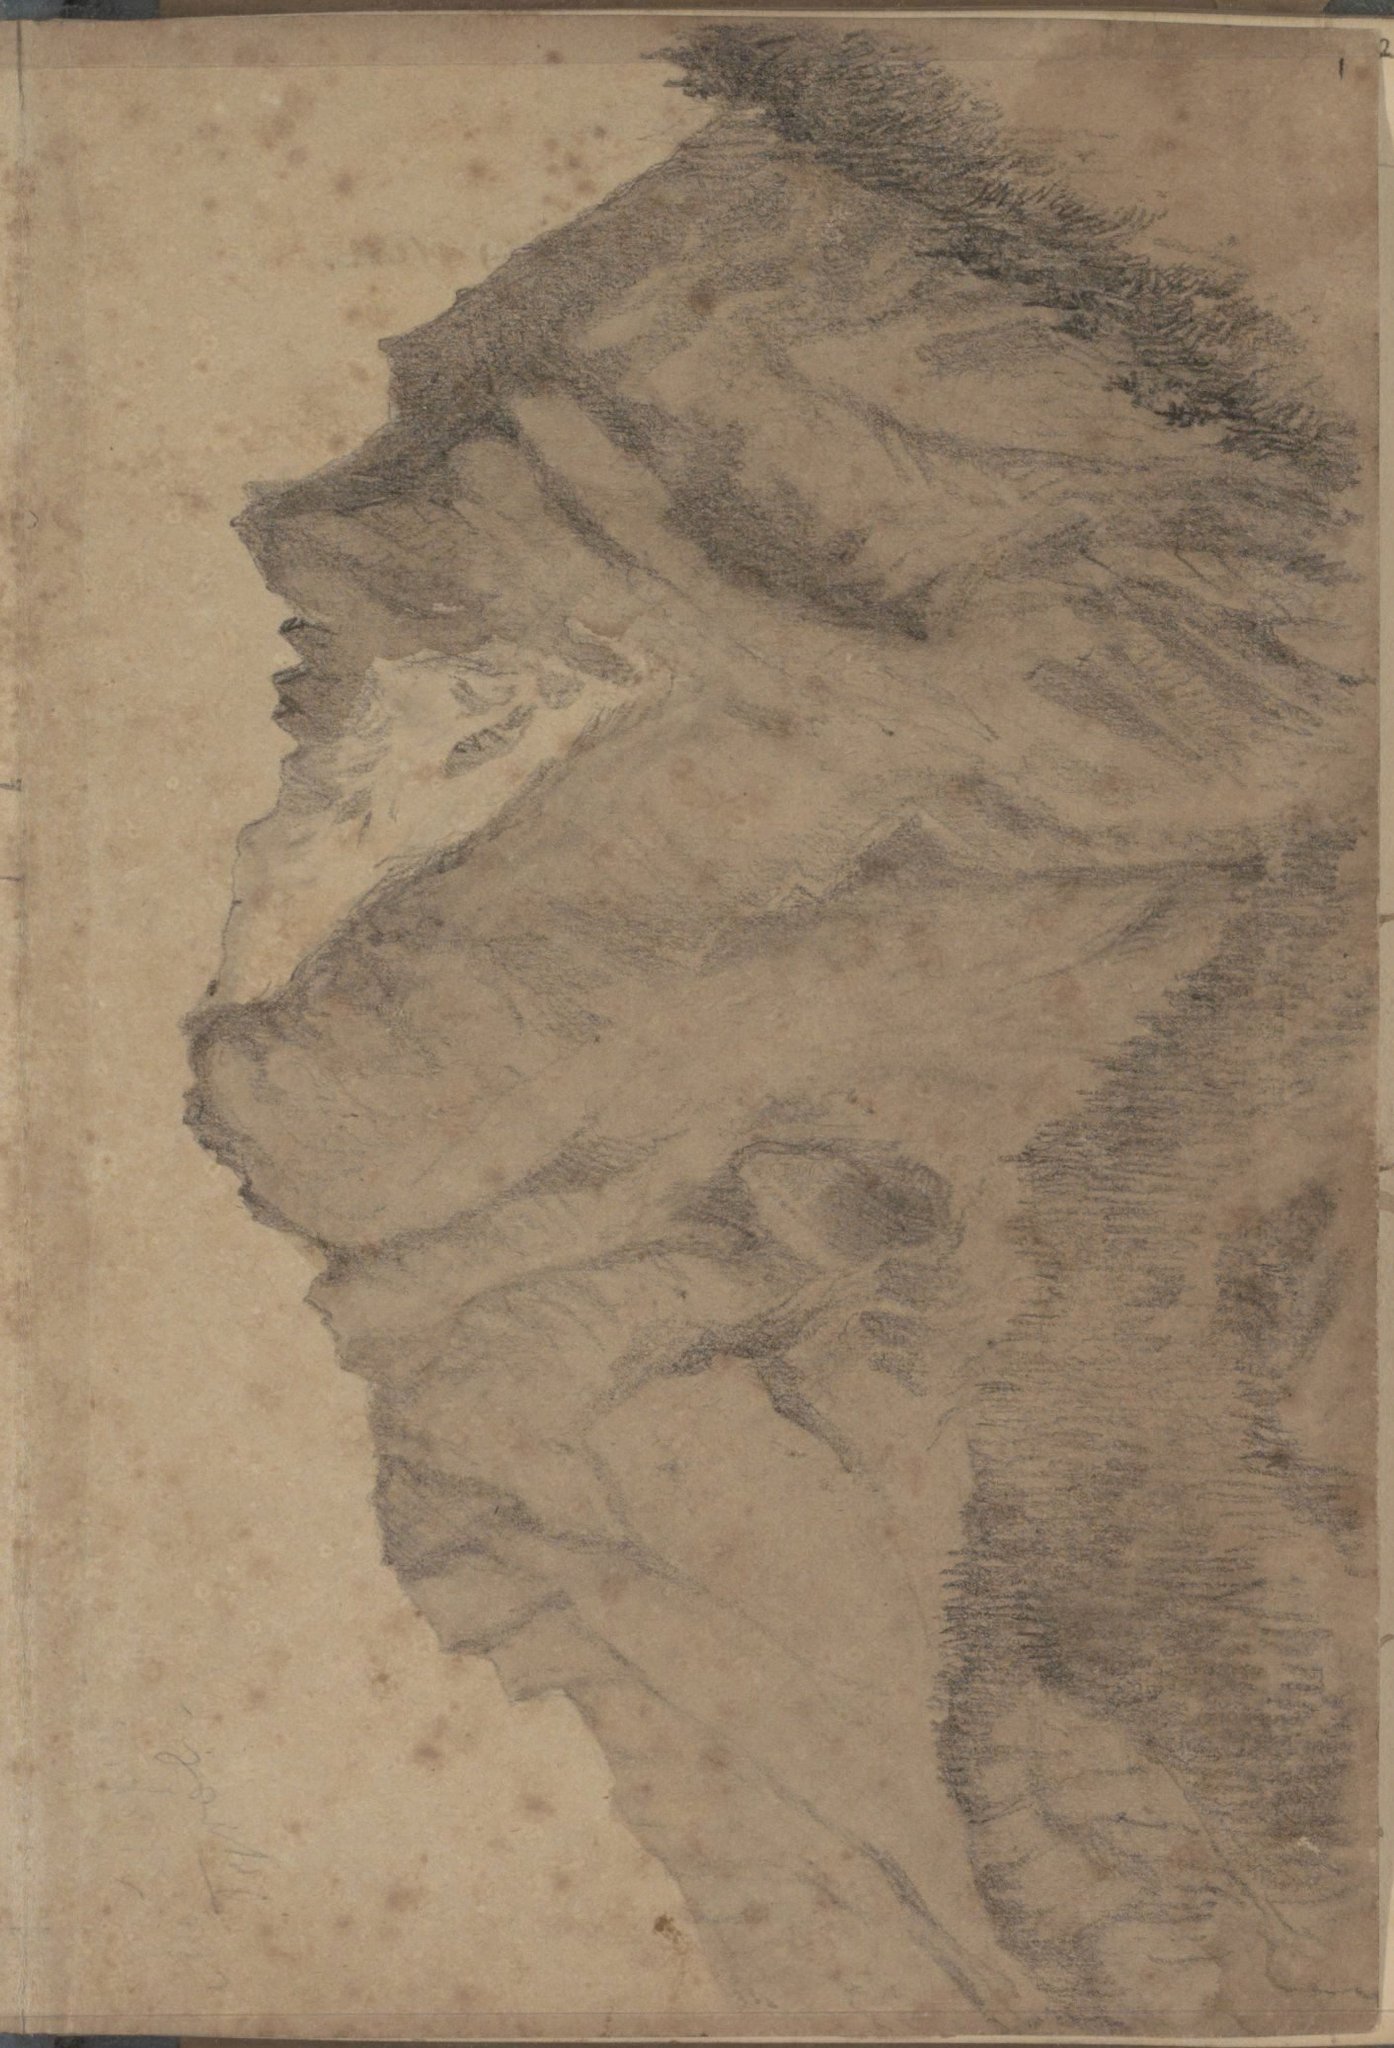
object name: sketchbook leaf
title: Bergen in Tirol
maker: johannes tavenraat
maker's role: draughtsman, painter, print maker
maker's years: 1809-1881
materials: ink, paper, pencil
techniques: brush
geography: tirol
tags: mountains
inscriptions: annotation: ‘Tyrol’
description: Blad 1 recto uit een schetsboek met 47 bladen.